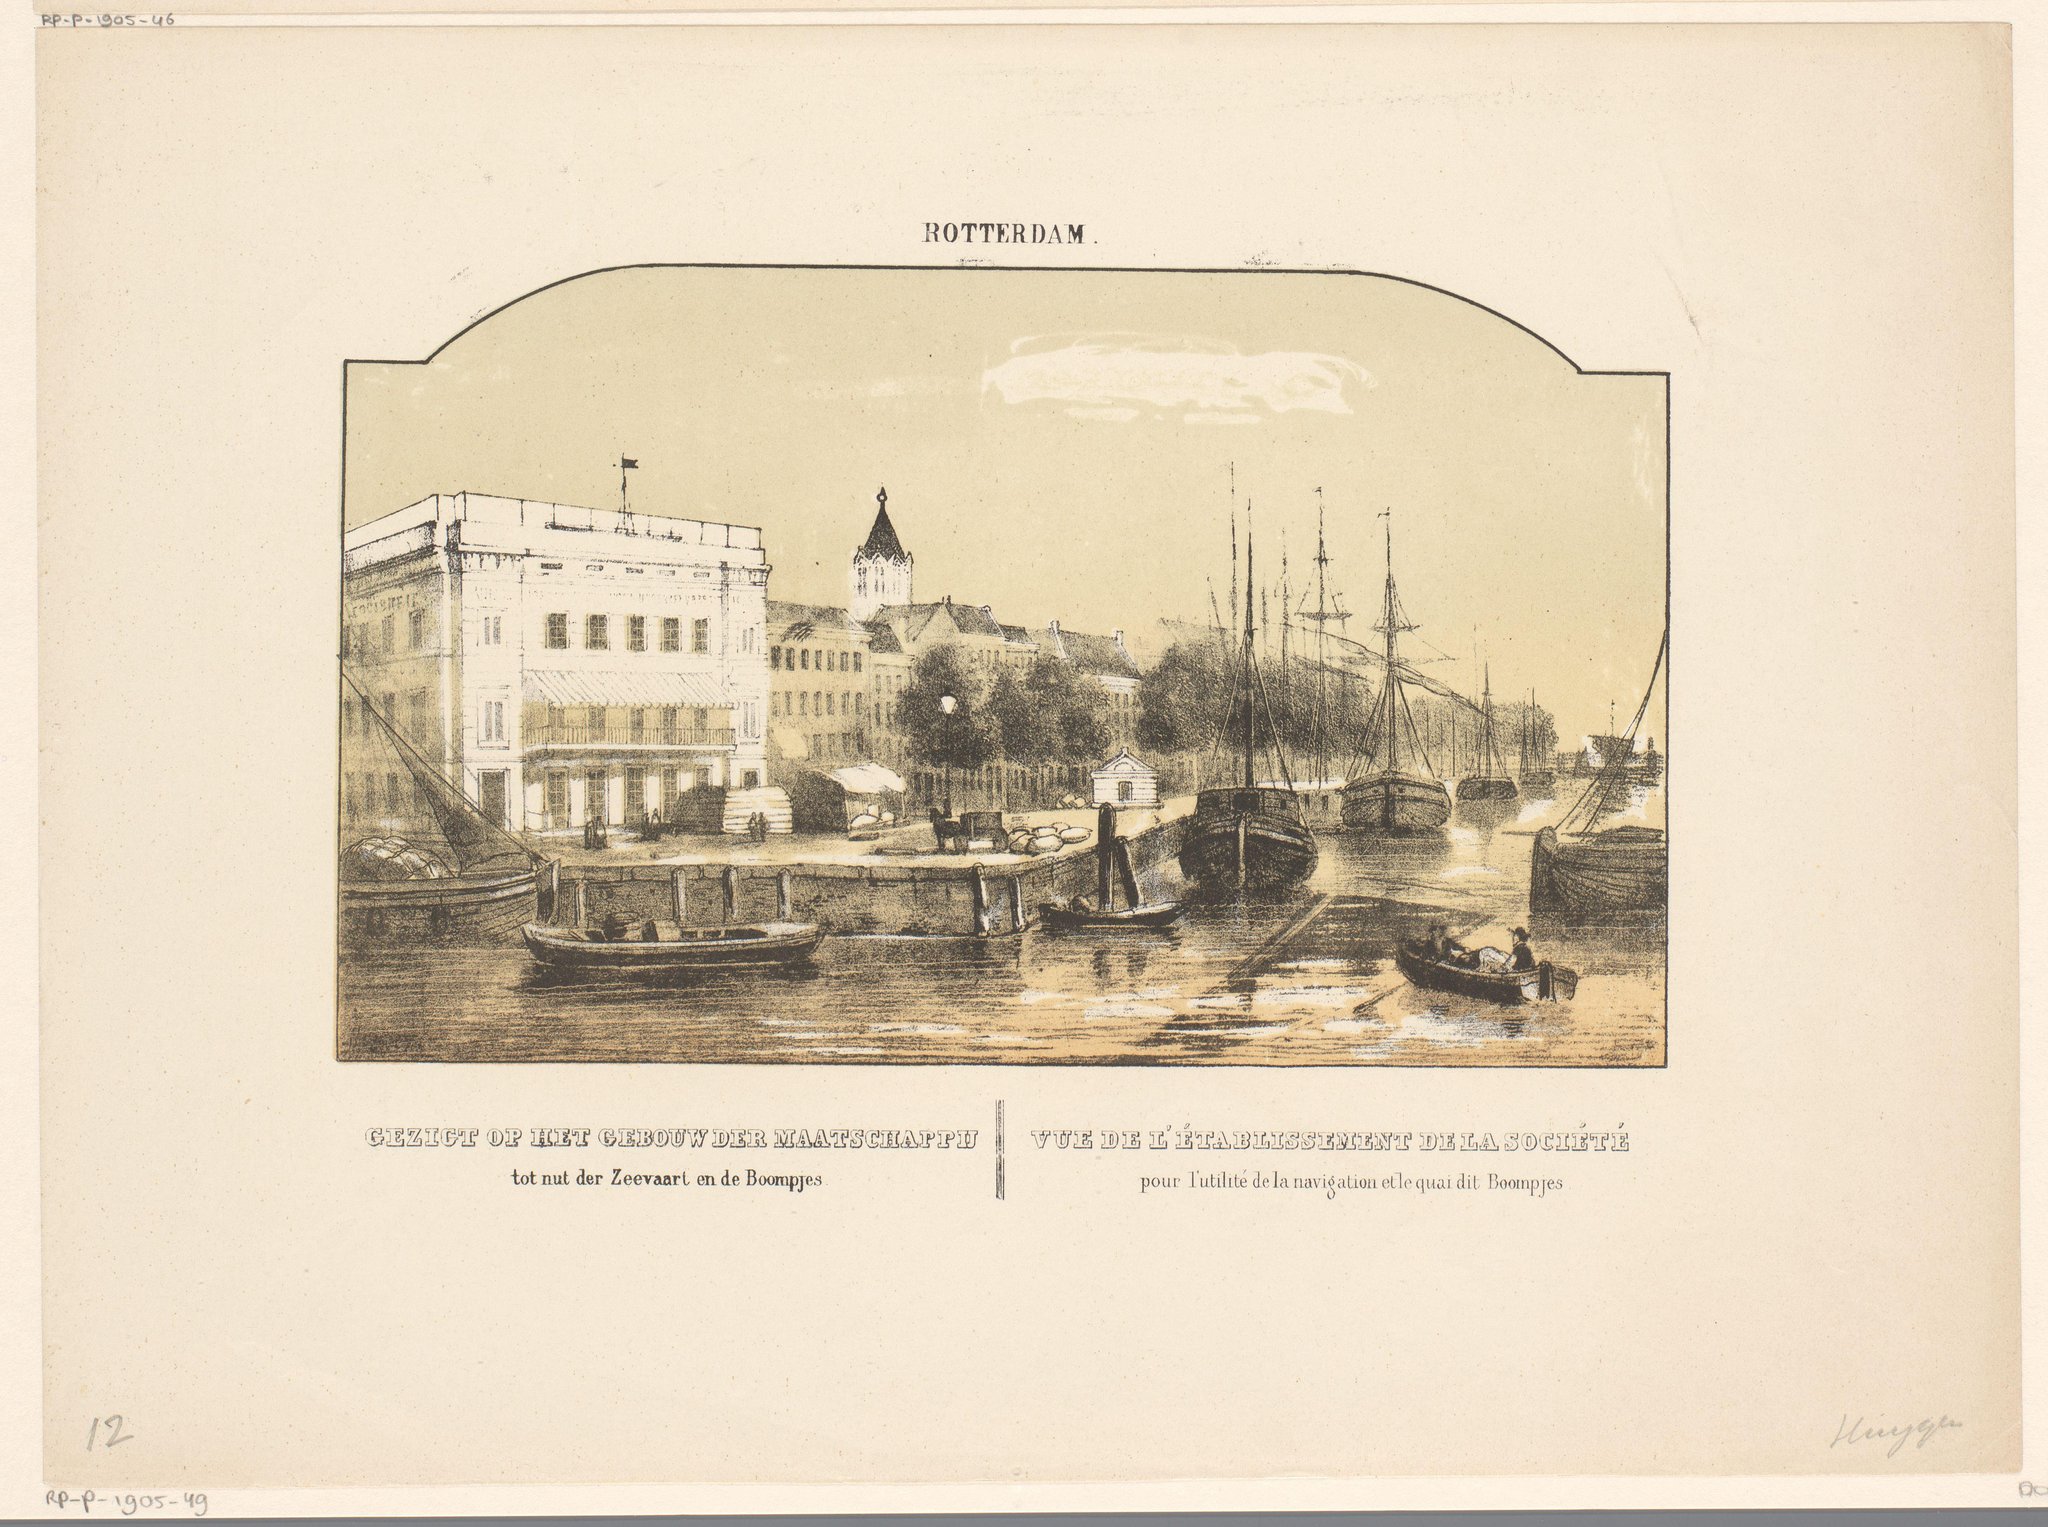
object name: print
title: Gezigt op het gebouw der Maatschappij tot nut der Zeevaart en de Boompjes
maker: frederik lodewijk huygens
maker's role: draughtsman, print maker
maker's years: 1802-1887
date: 1812-1887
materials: paper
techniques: iris print, lithograph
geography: netherlands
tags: canals, waters (in city), city-view, and landscape with man-made constructions (+ city(-scape) with figures, staffage), rotterdam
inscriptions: collector's mark: Lugt 2228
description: Maakte deel uit van een serie over Rotterdam, zie RP-P-1905-46 t/m RP-P-1905-53. Nummer RP-P-1905-46 is gesigneerd.